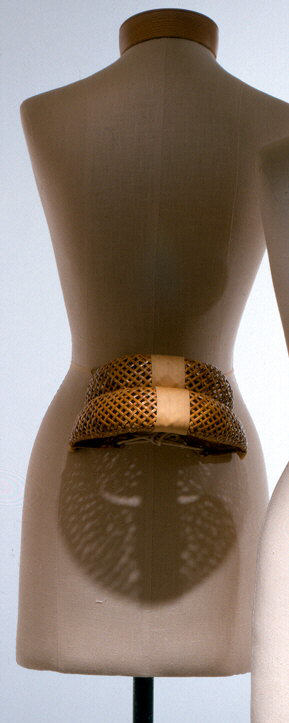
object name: bustle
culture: american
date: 1880-1889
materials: cotton